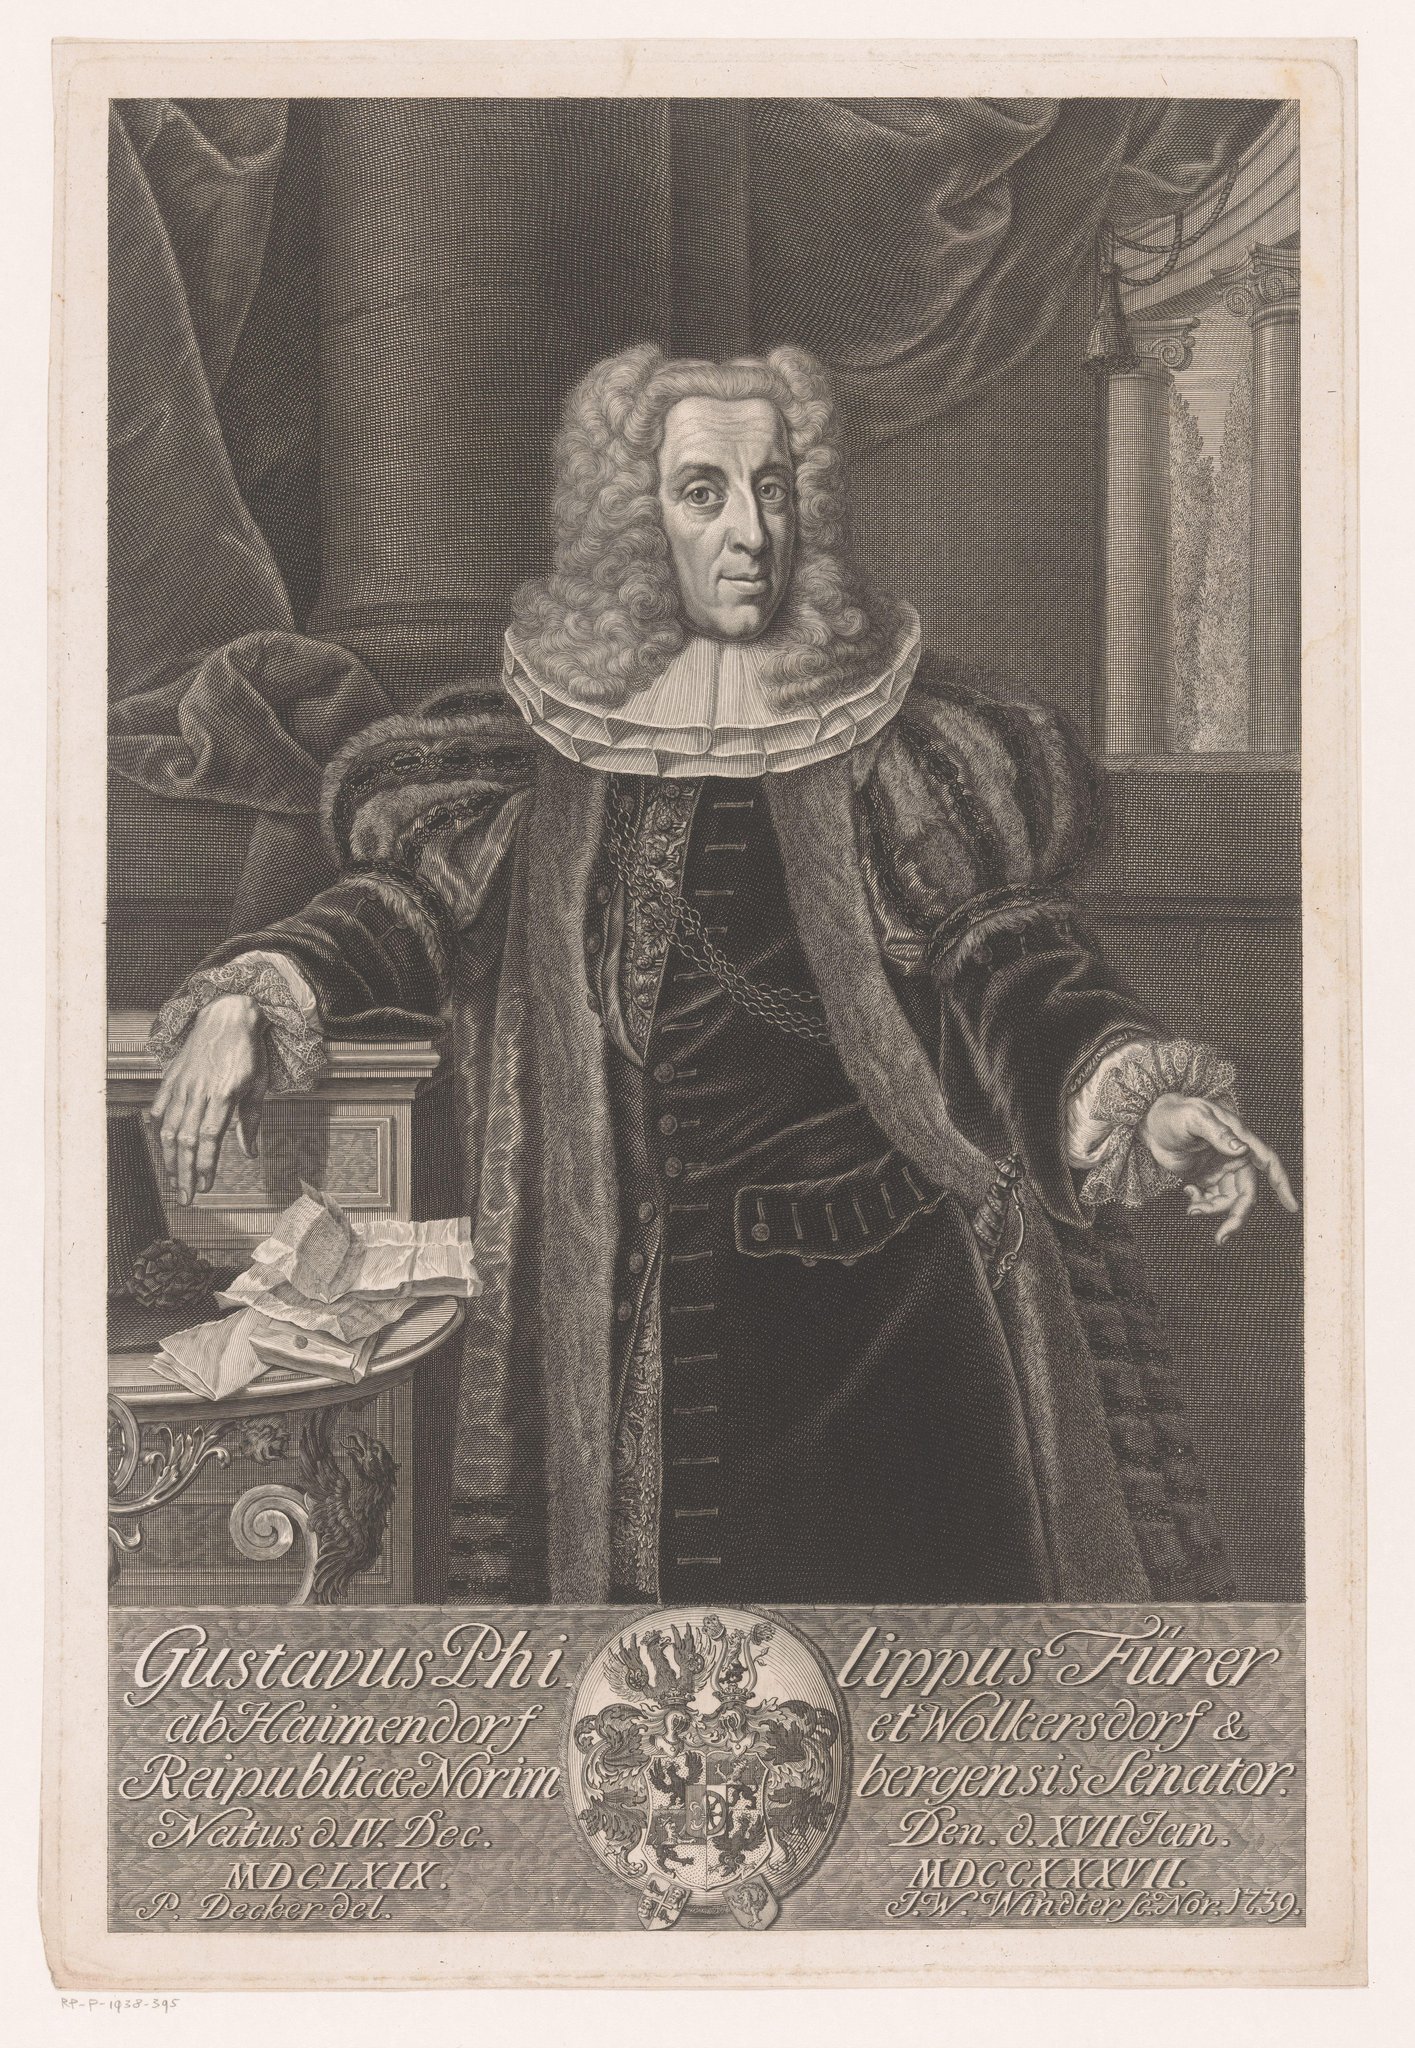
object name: print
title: Portret van Christoph Fürer von Haimendorf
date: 1739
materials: paper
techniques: engraving, etching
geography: nuremberg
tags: mayor, historical persons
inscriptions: collector's mark: Lugt 2228